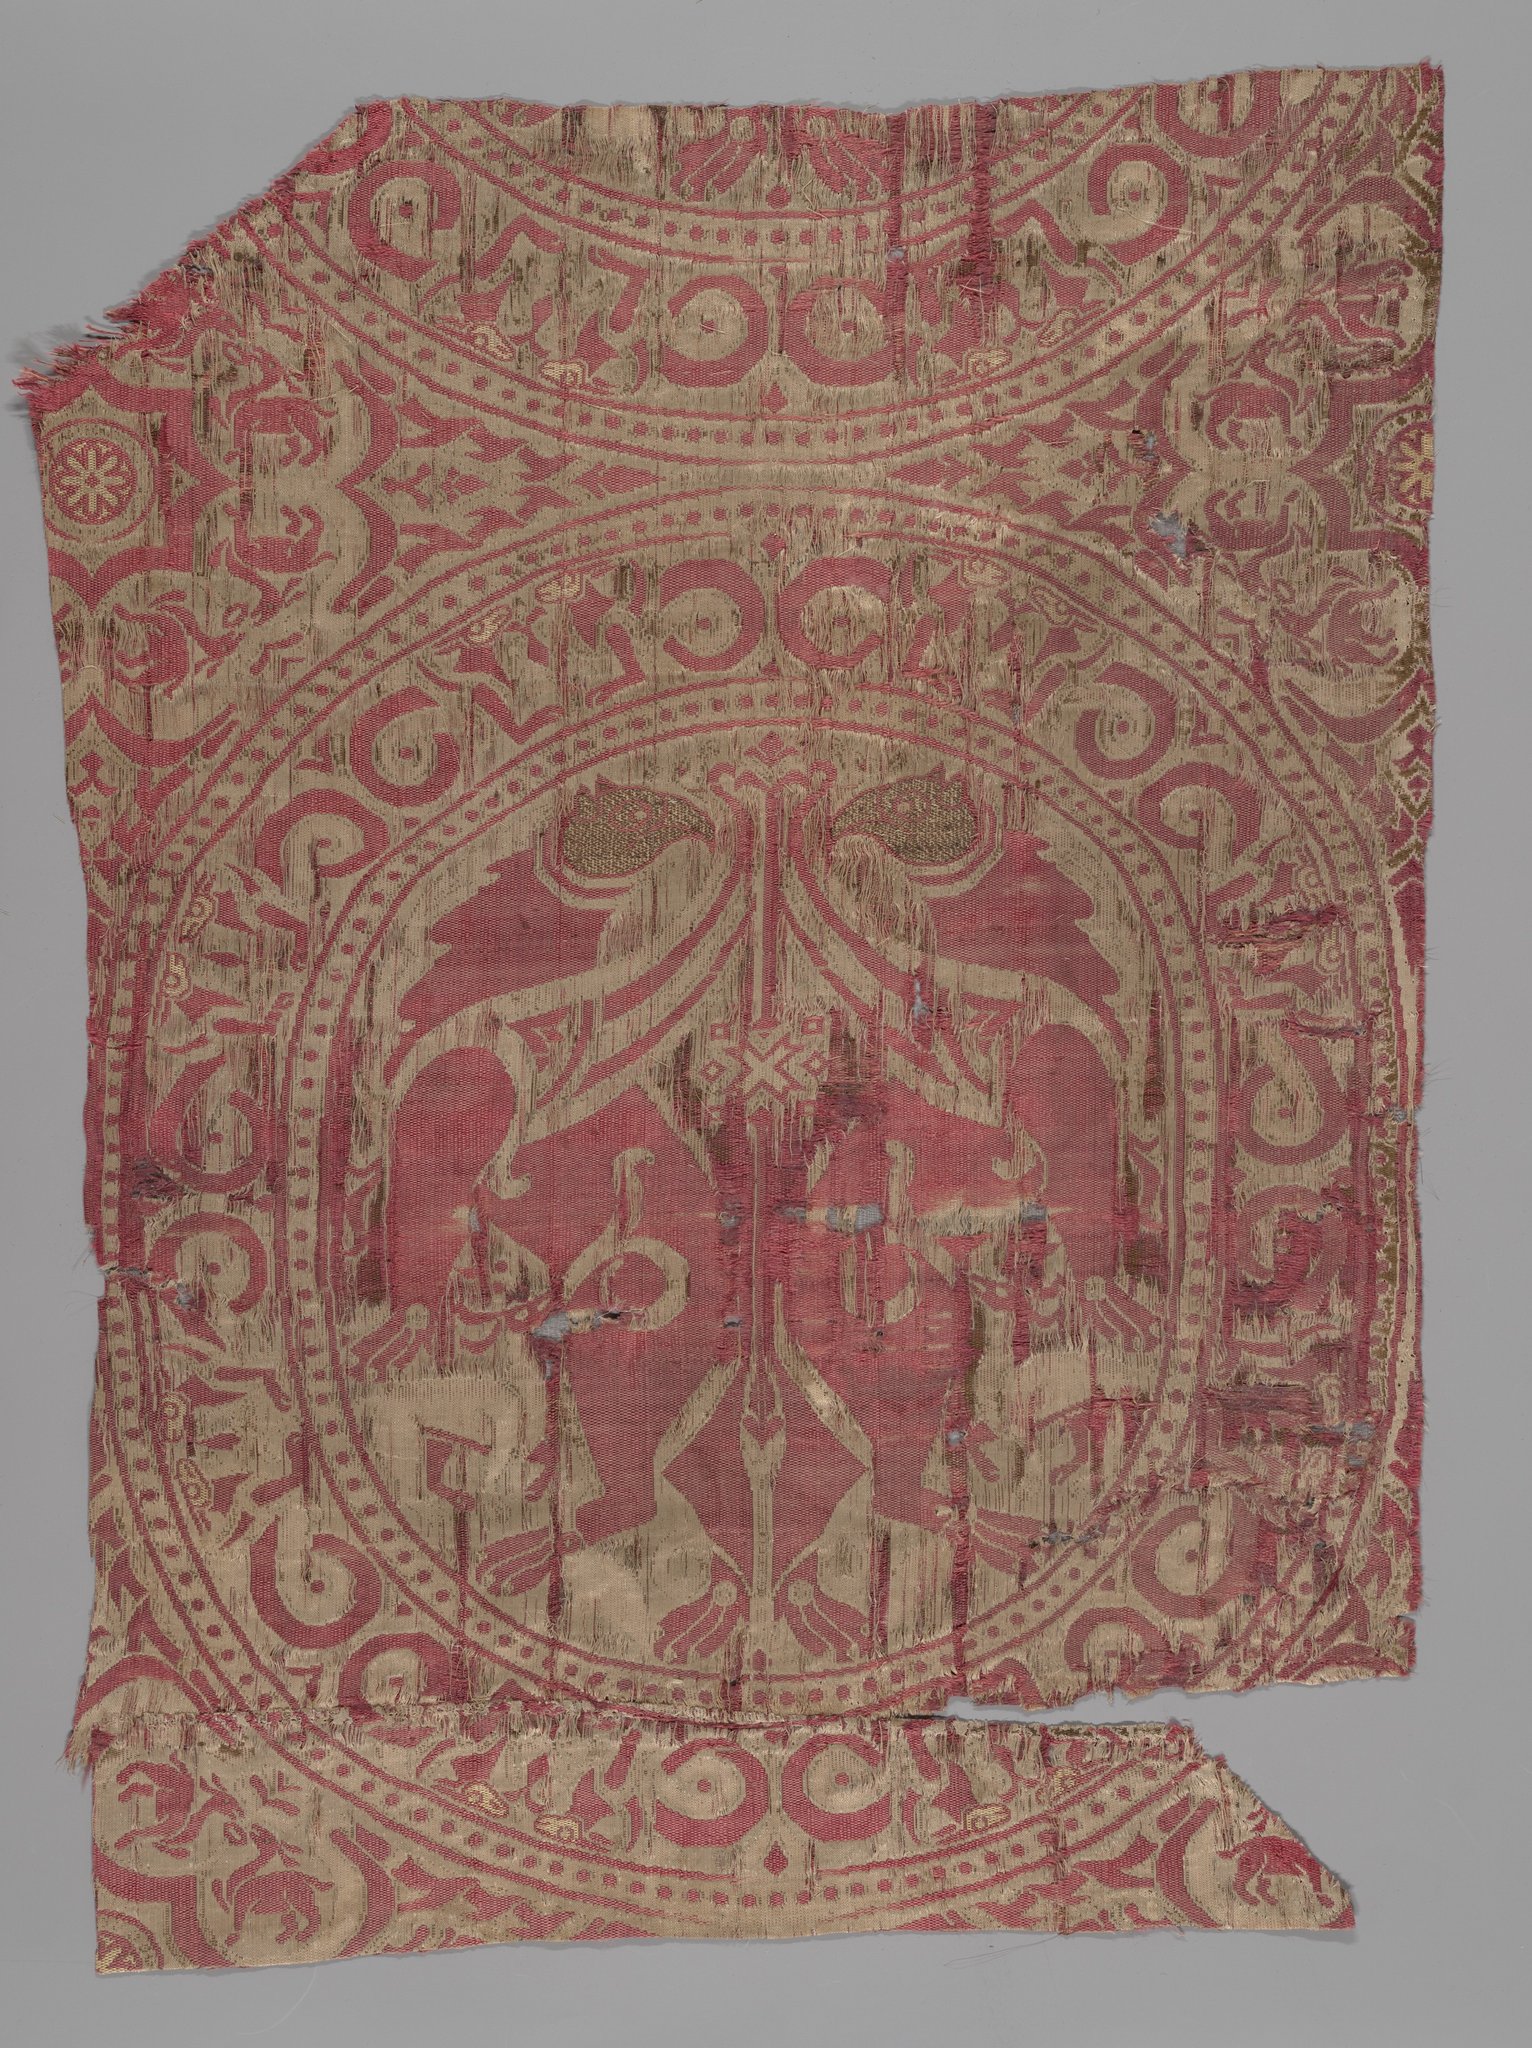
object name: texile fragment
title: Textile Fragment from the Shrine of San Librada, Sigüenza Cathedral, Spain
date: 1101-1150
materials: metal thread, silk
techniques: lampas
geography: spain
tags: animals,griffins